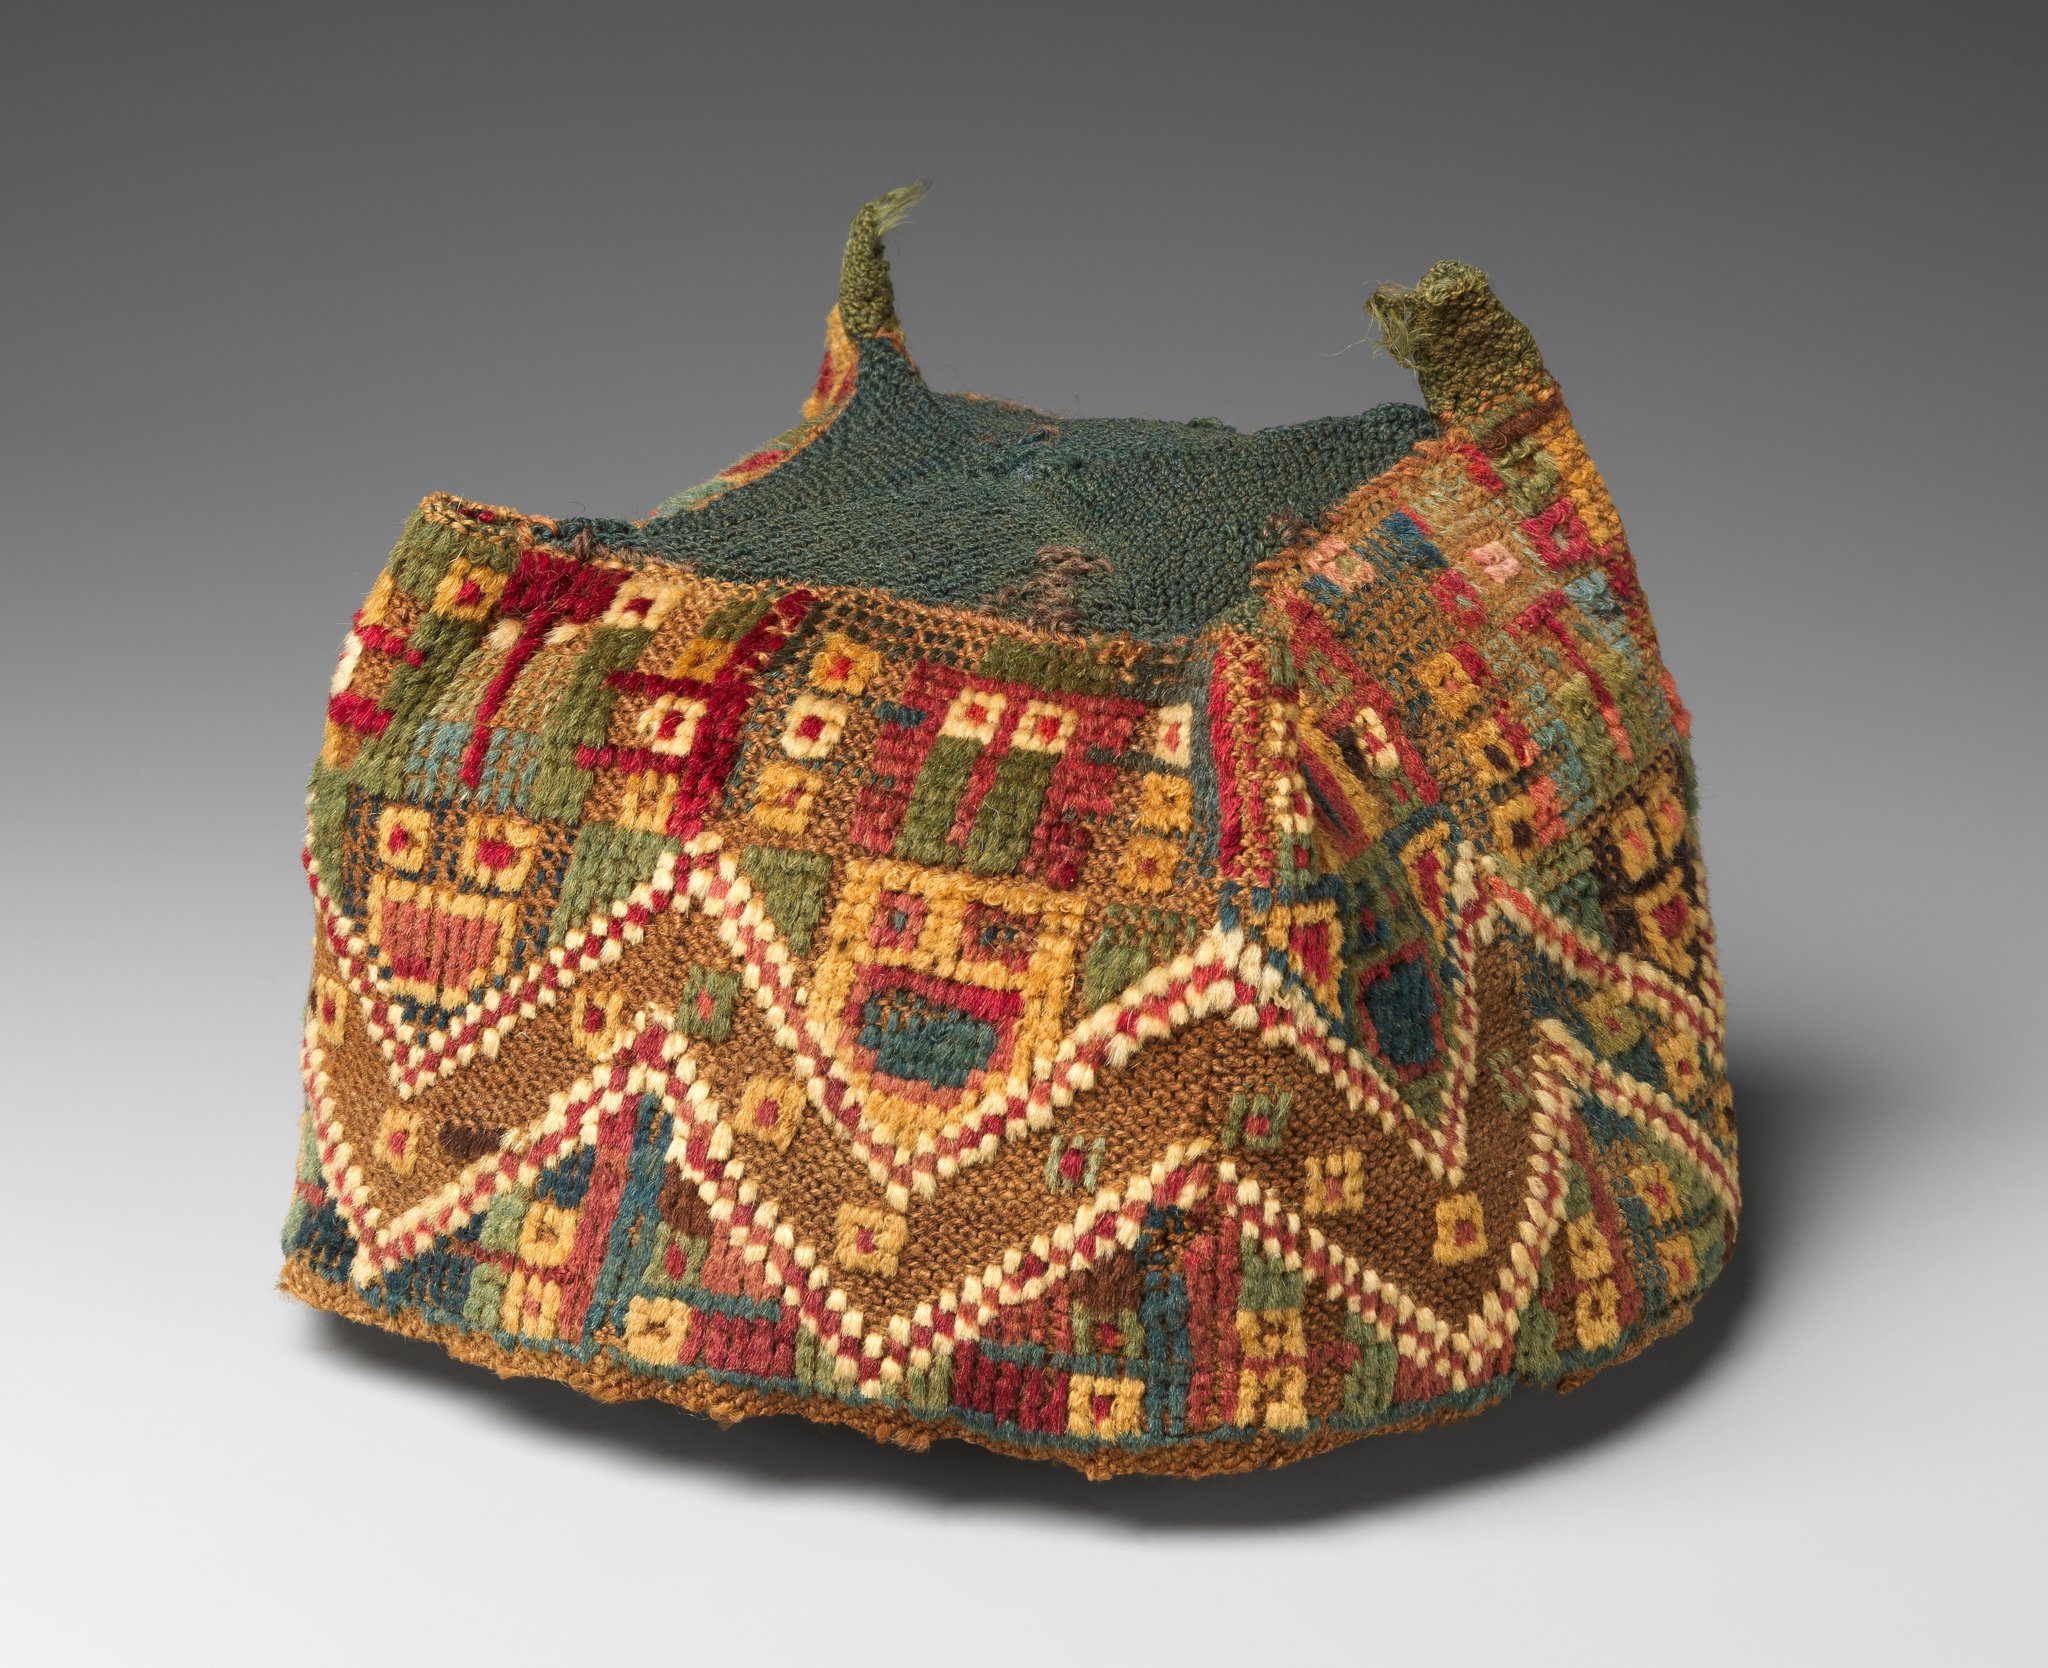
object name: hat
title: Four-Cornered Hat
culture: wari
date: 601-900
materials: animal fiber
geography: peru